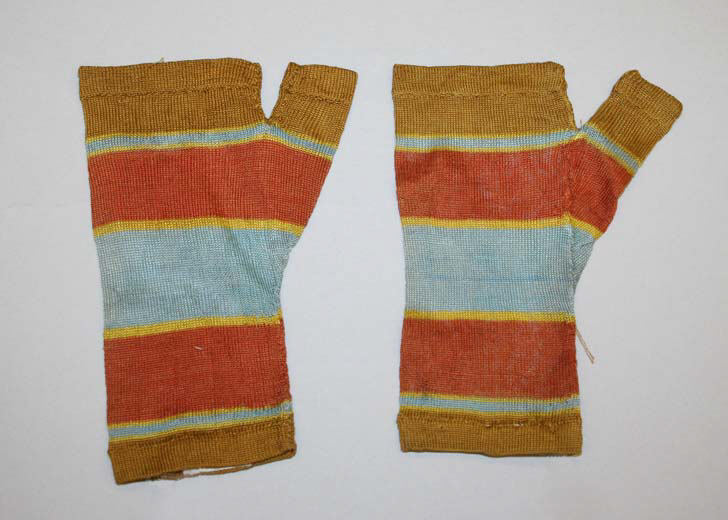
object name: mitt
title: Mitts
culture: italian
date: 1850-1860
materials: silk